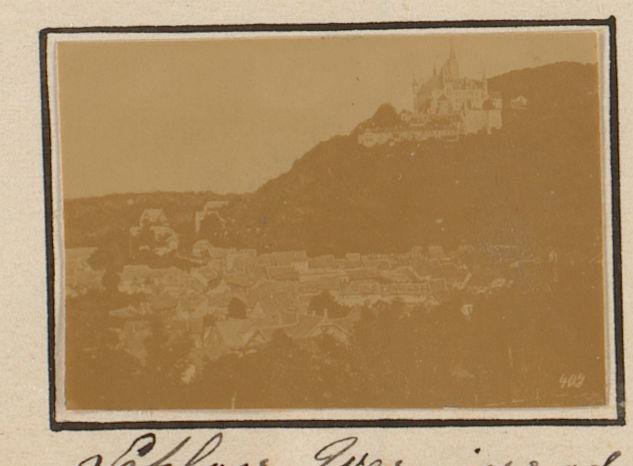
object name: album leaf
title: Gezicht op Wernigerode met Kasteel Wernigerode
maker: Anonymous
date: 1885-1891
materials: photographic support, plant material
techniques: albumen print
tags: city-view in general; 'veduta', castle, mountains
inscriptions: annotation: ‘Schlosz Weringrode’, annotation: ‘den ganschen Harz. Jet/ heeft visioenen van een [...]/ (...)’